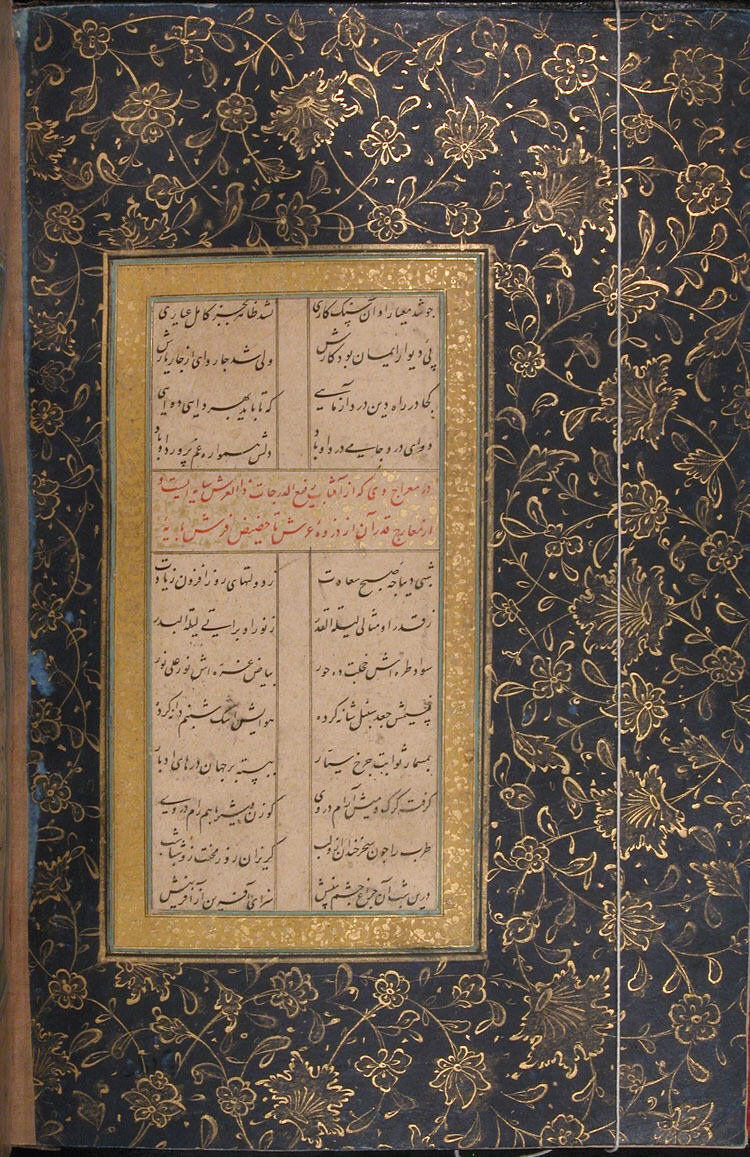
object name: illustrated manuscript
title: Yusuf and Zulaykha of Jami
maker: mir 'ali al-husaini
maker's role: calligrapher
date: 1523-1524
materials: gold, ink, leather, paper, watercolor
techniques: bookbinding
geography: uzbekistan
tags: flowers,calligraphy